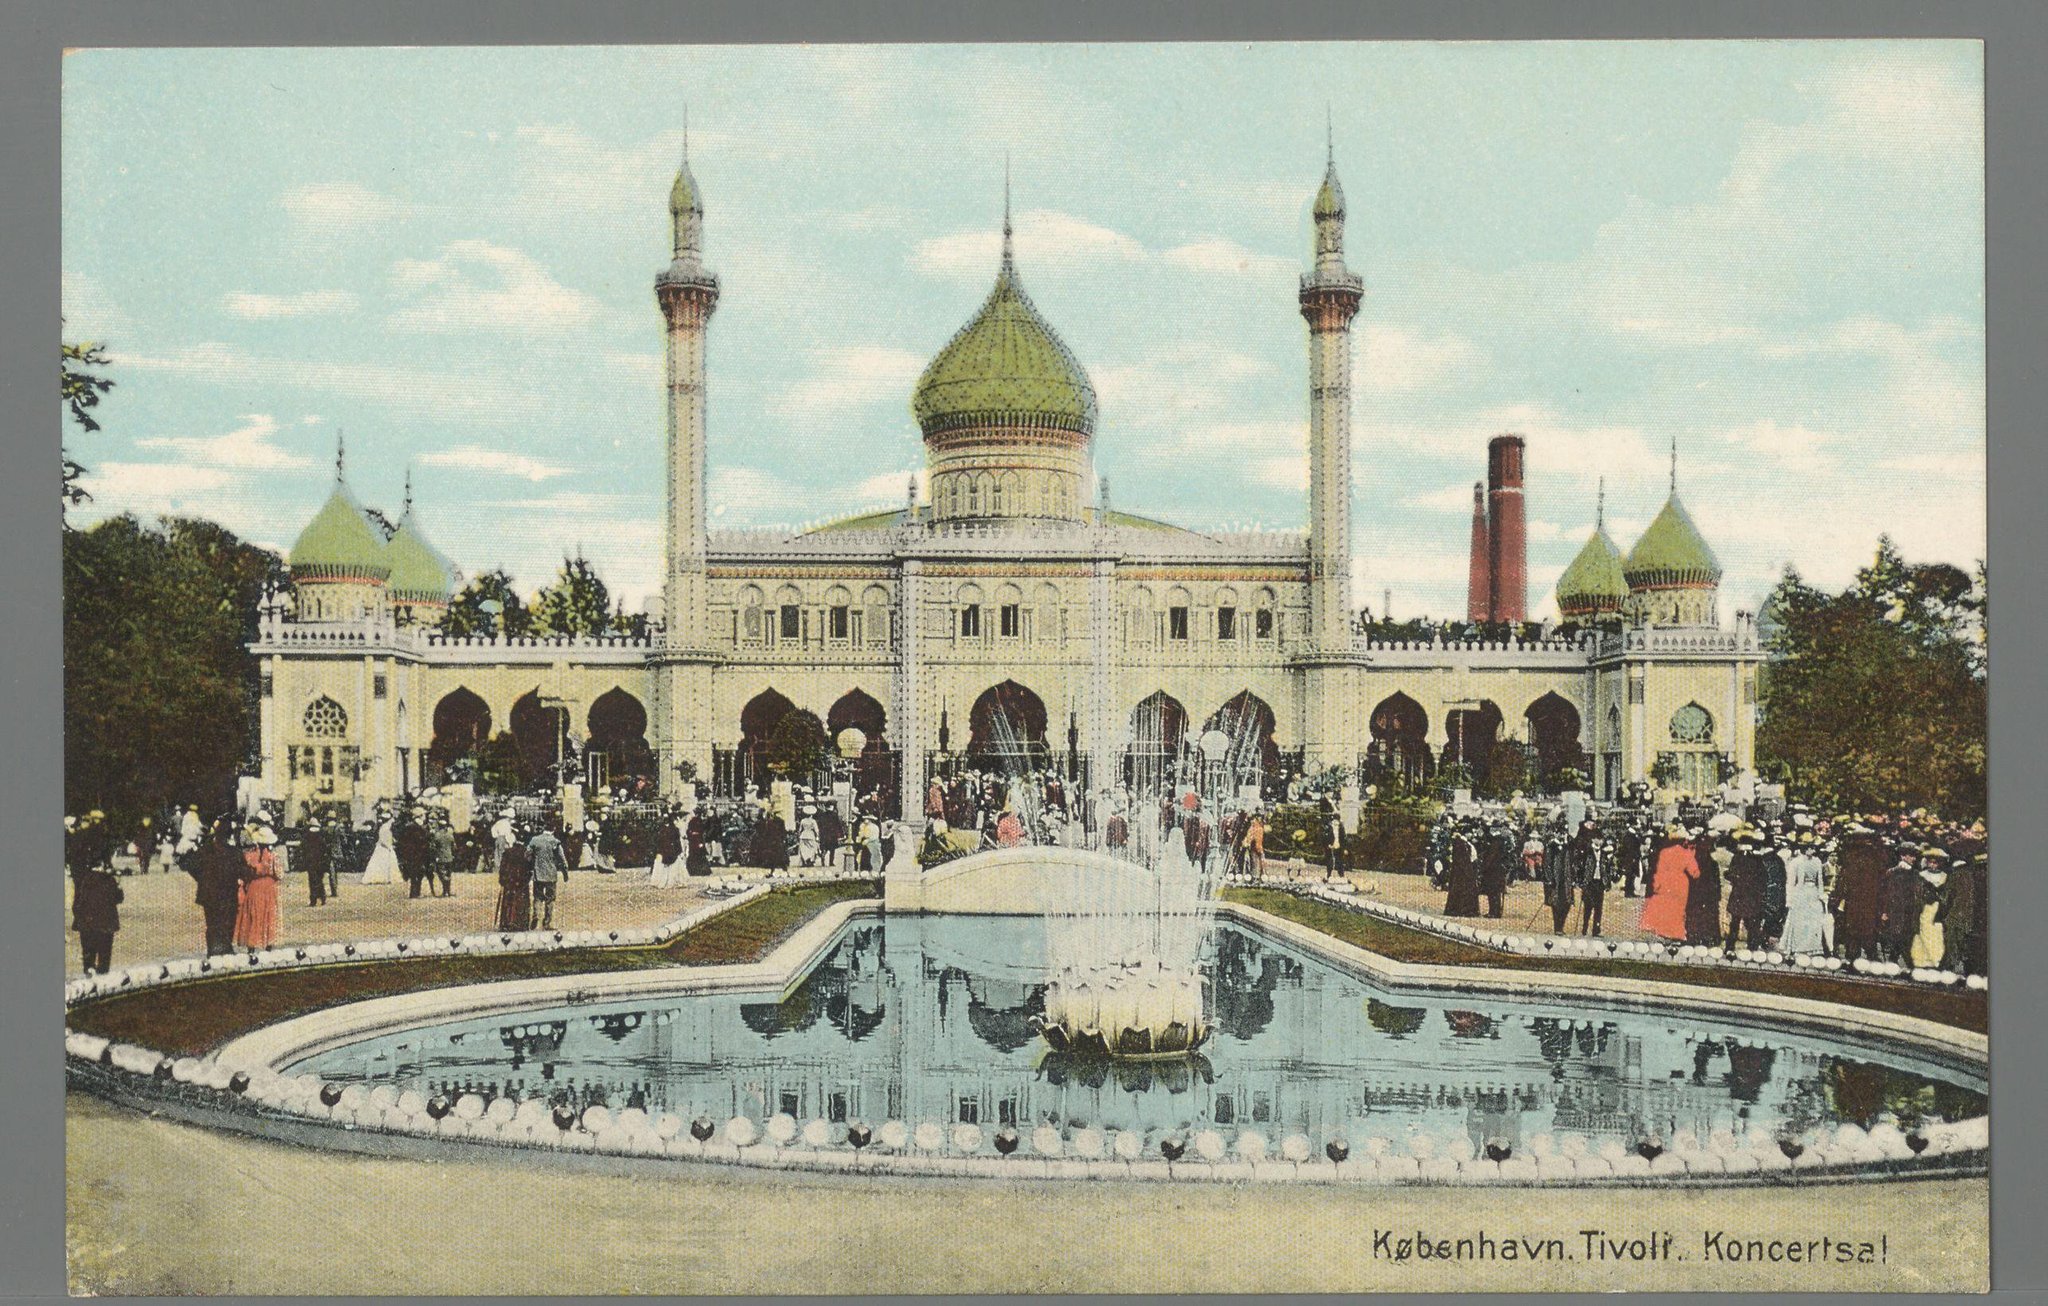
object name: photomechanical print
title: København. Tivoli. Koncertsal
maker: Anonymous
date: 1906-1920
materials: cardboard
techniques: photograph, lithograph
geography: copenhagen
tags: public gardens, park (+ city(-scape) with figures, staffage), concert hall, copenhagen (city)